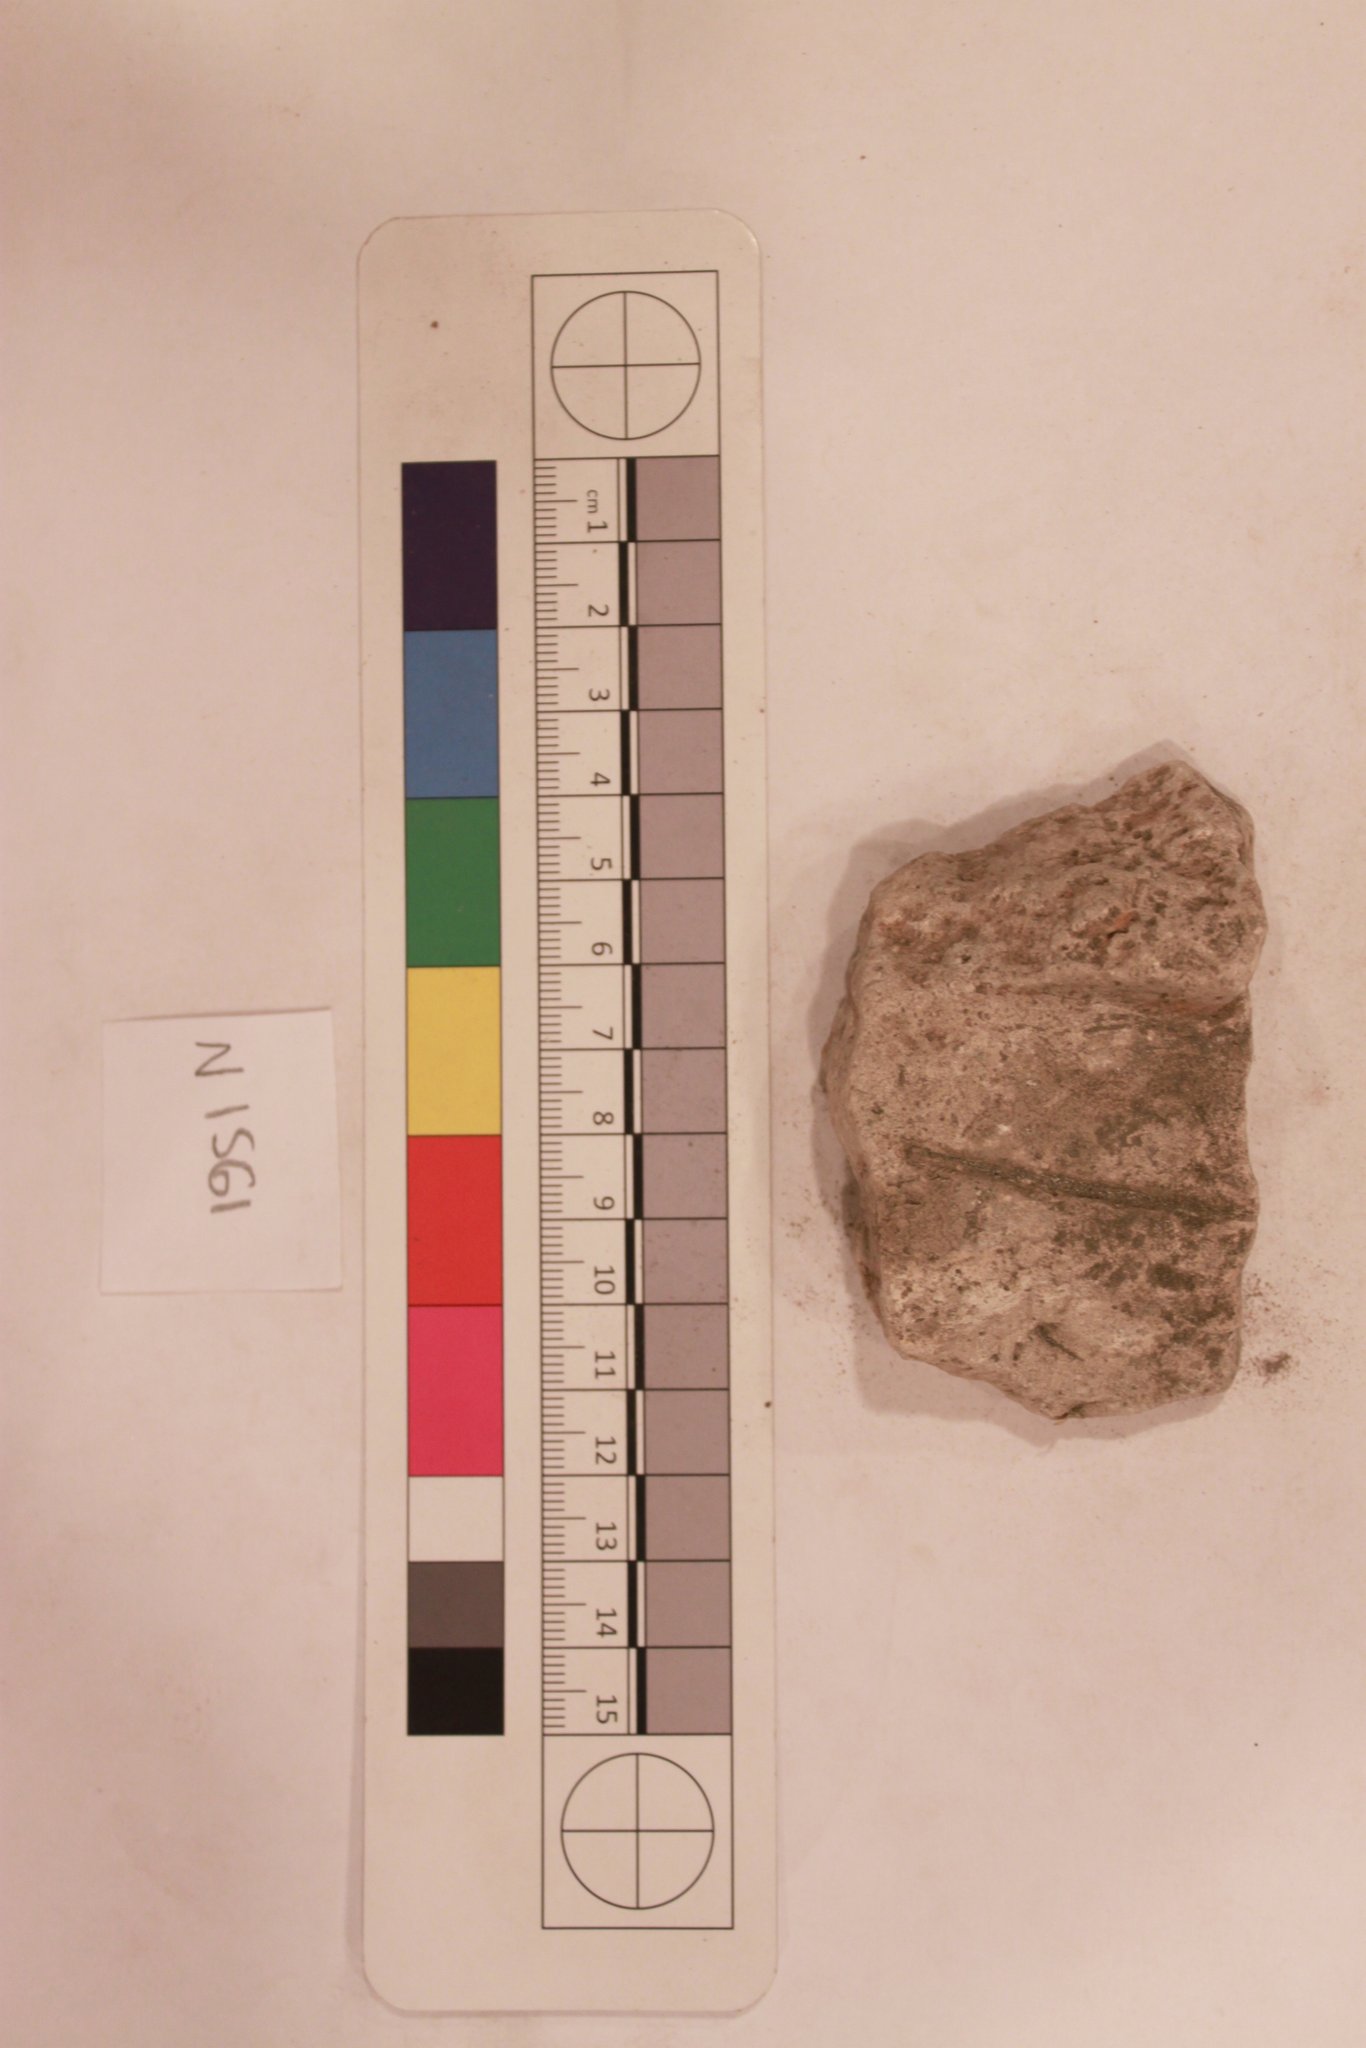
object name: fragment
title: Stucco Fragment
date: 701-1200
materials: plaster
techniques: carving, painting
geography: iran